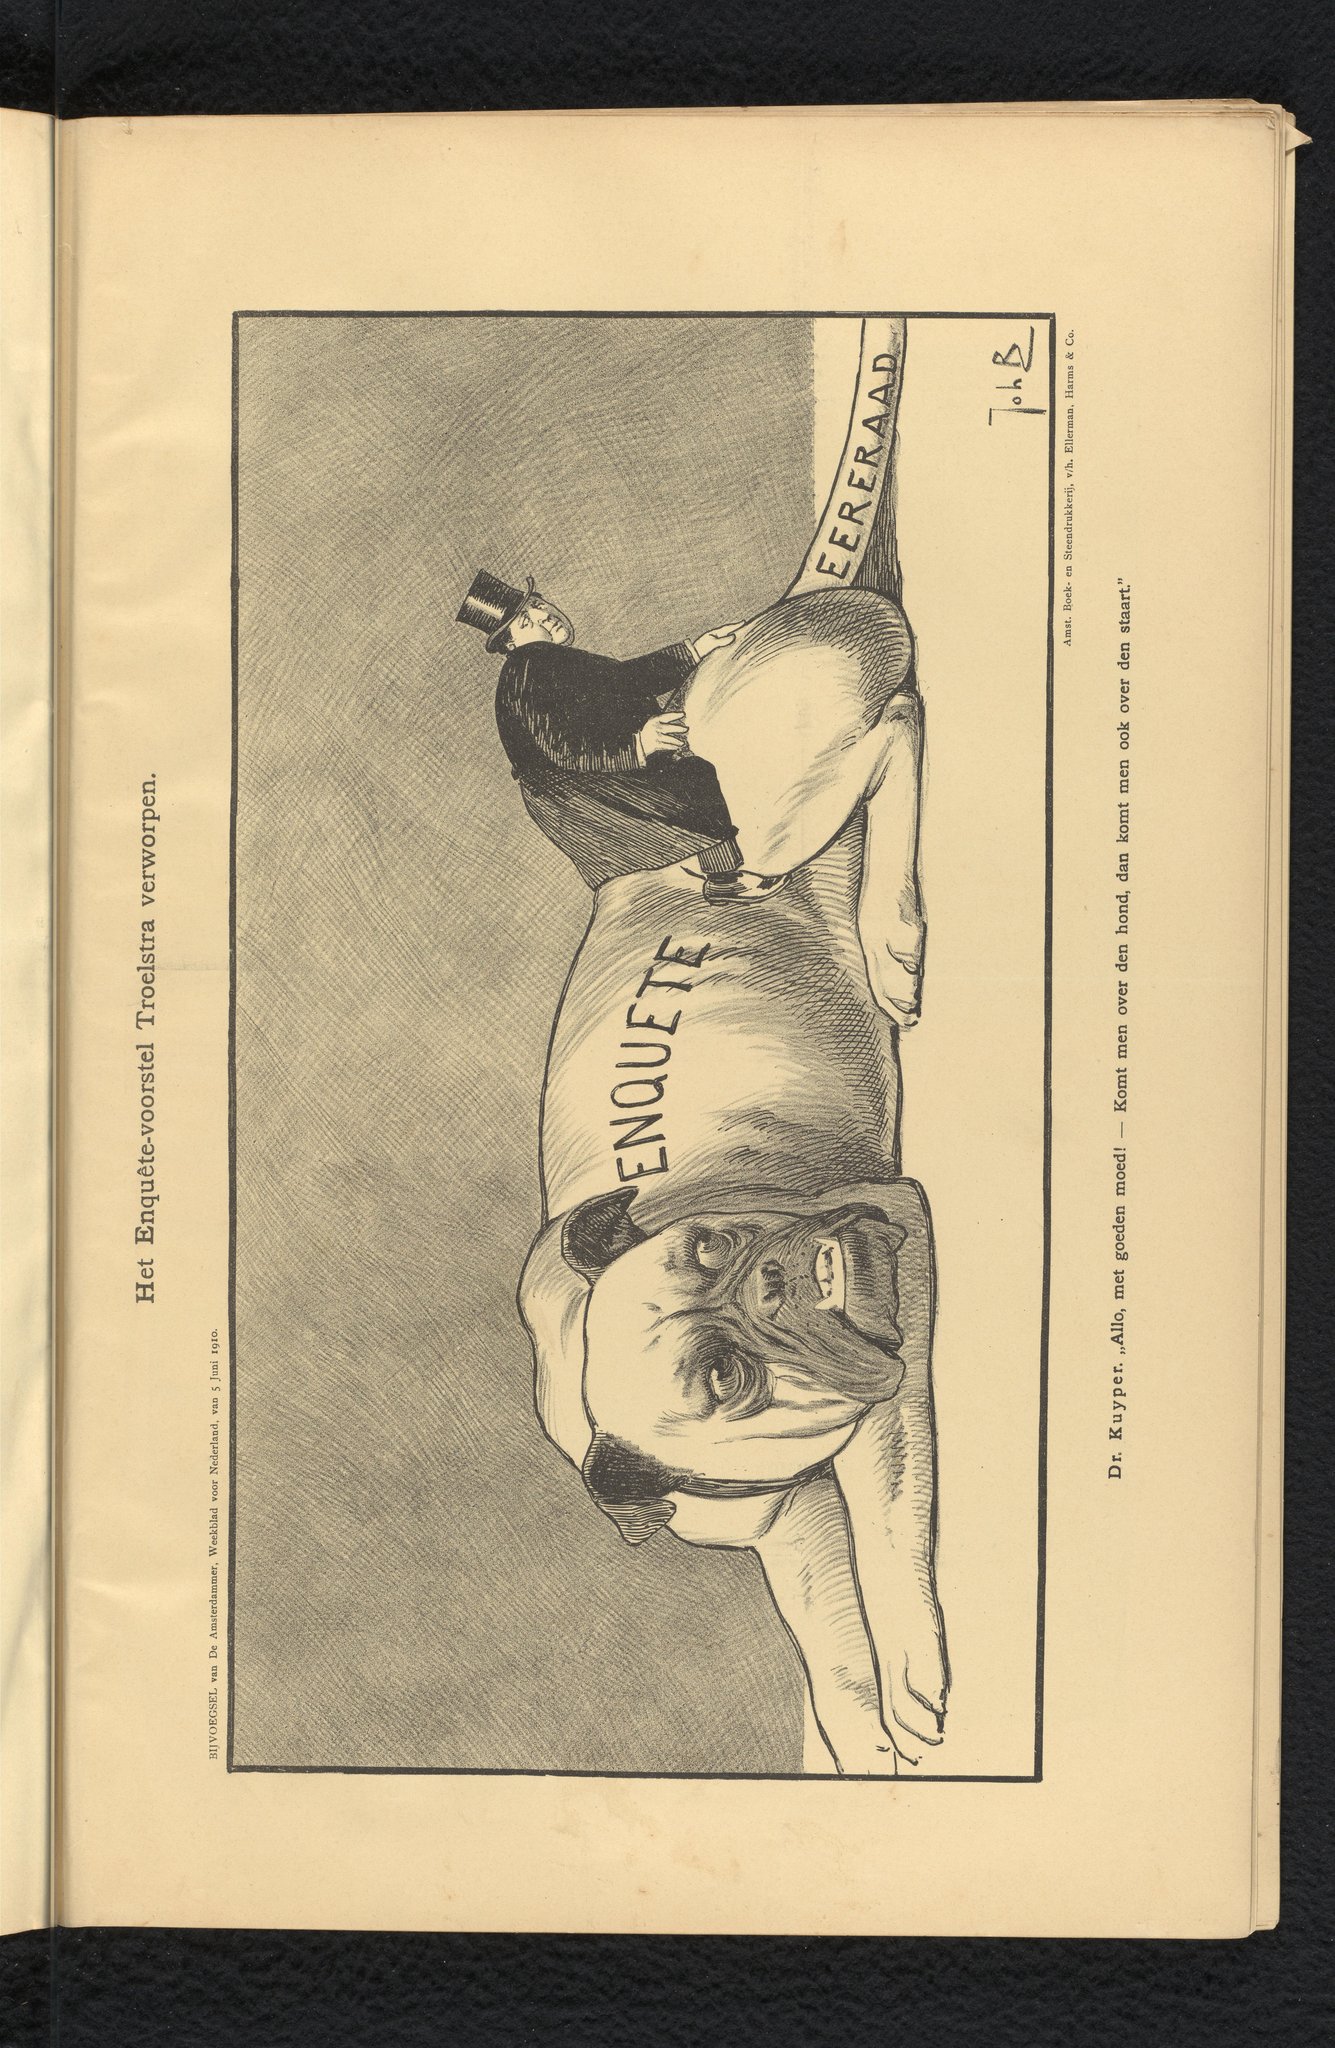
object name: cartoon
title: Het Enquête-voorstel Troelstra verworpen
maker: johan braakensiek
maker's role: draughtsman, print maker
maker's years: 1858-1940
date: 1910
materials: paper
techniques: lithograph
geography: netherlands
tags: politician, the hague, abraham kuyper, political caricatures and satires, dog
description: Abraham Kuyper klimt voorzichtig over een grote hond, een boxer. Naar aanleiding van het verwerpen van een voorstel van Pieter Jelles Troelstra over een enquête.